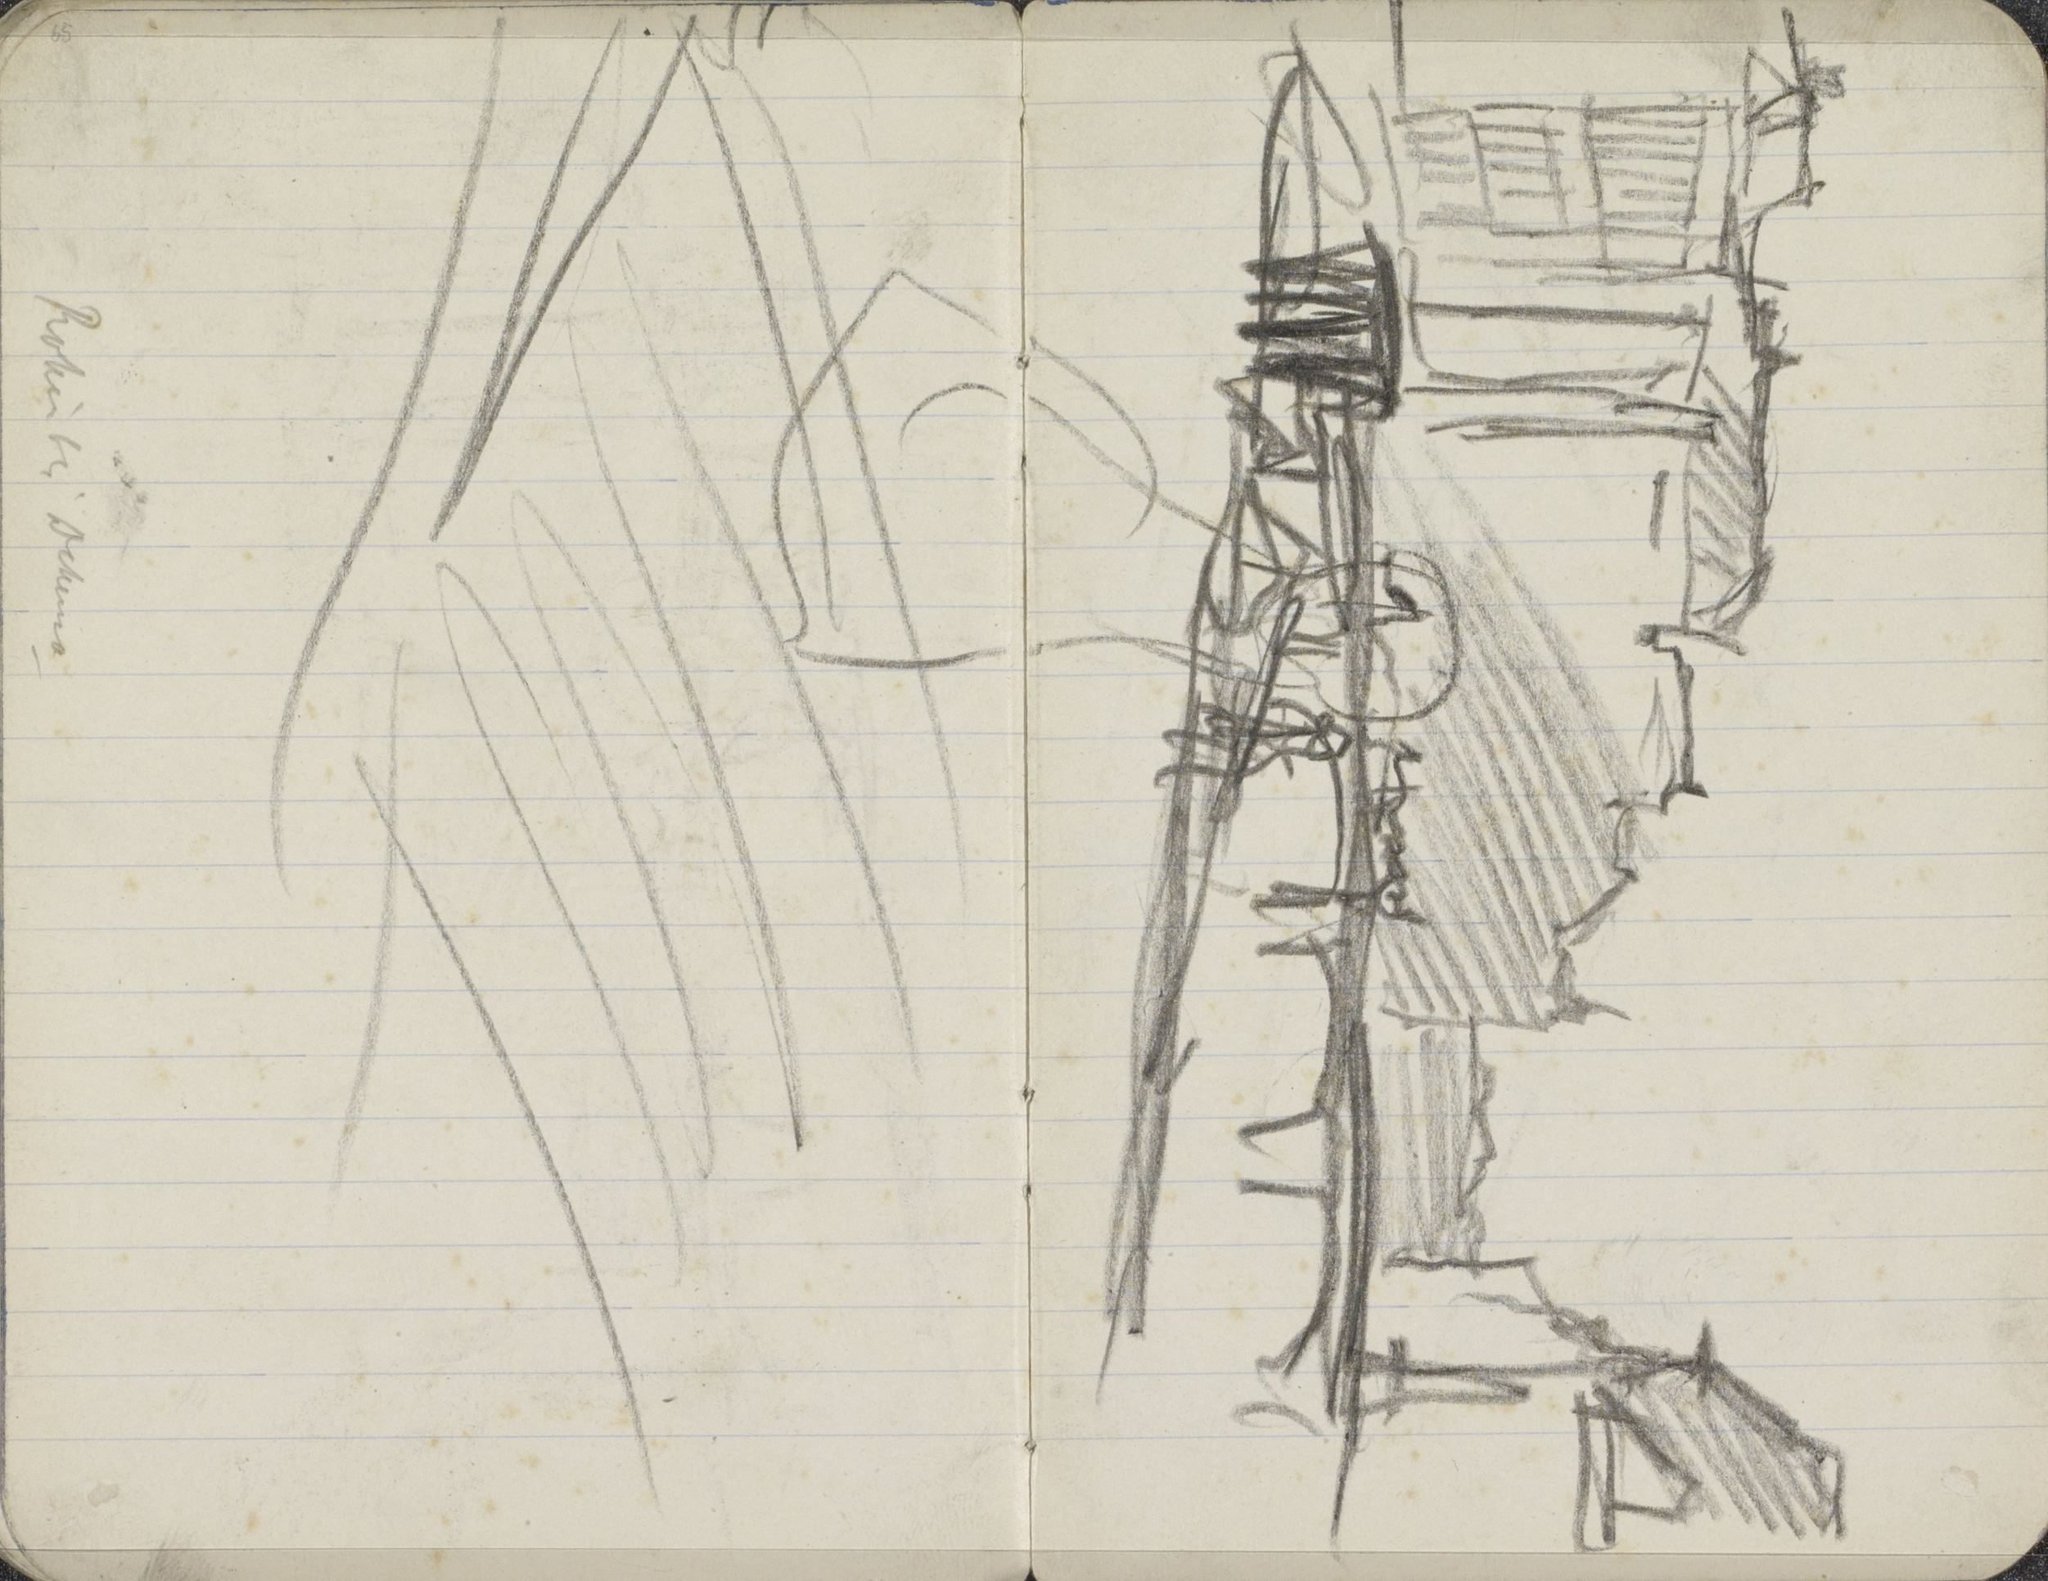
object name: sketchbook leaf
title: Gezicht op het Rokin met de Langebrug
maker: george hendrik breitner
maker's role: draughtsman, painter, print maker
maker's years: 1857-1923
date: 1898-1902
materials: chalk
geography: amsterdam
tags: bridge in city across river, canal, etc. (+ city(-scape) with figures, staffage)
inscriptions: annotation: ‘Rokin bij Dekema’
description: Gezien vanuit Rokin 138, Wegner en Mottu (destijds bedreven door Pieter Jan Dekema). Pagina 65 en pagina 66 uit een schetsboek met 42 bladen.